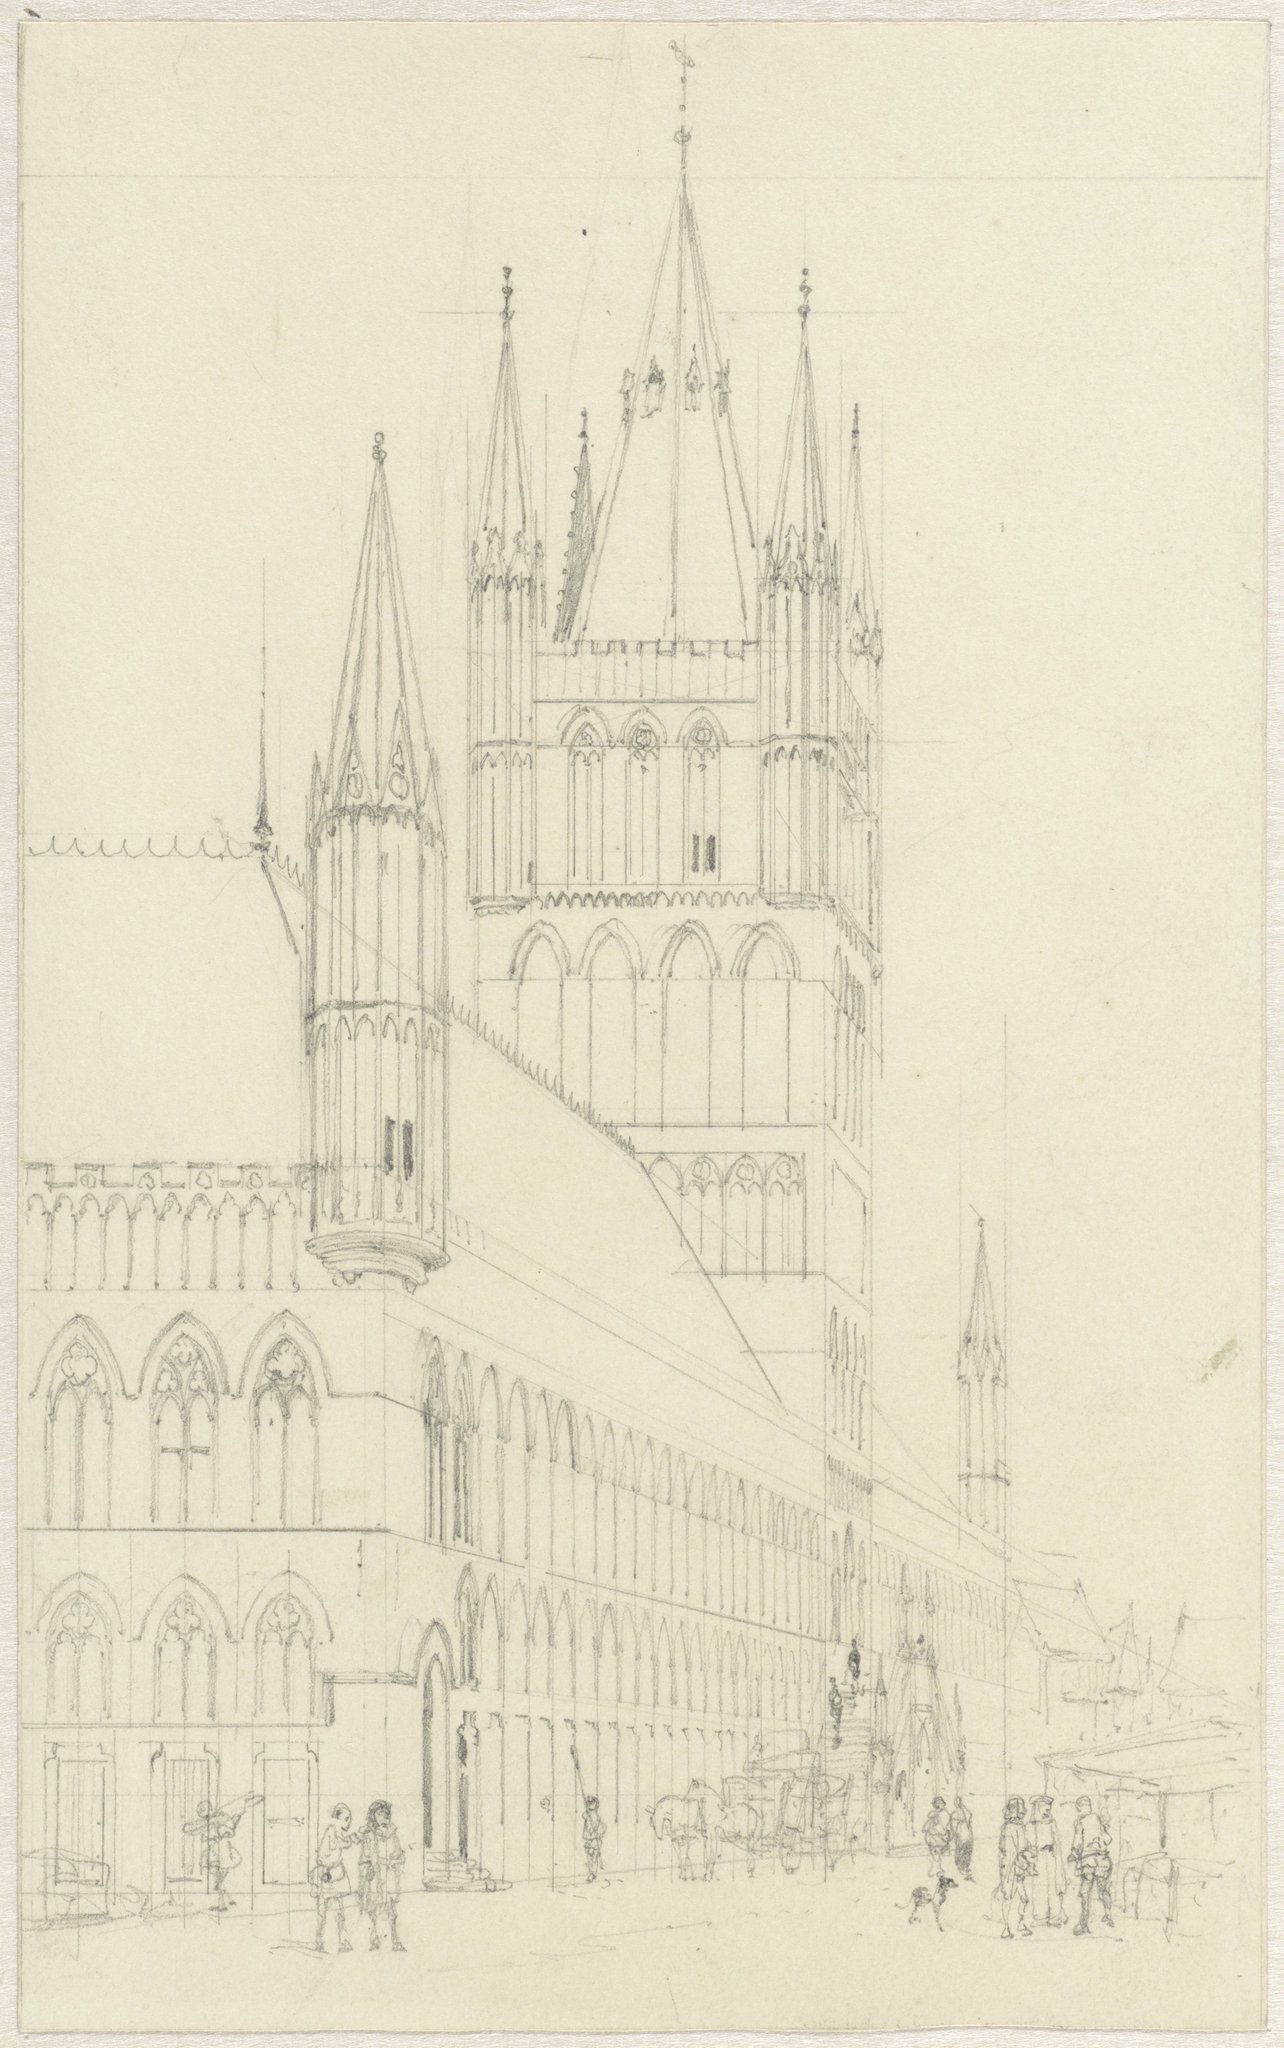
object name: drawing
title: Lakenhal te Yperen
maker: charles rochussen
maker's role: draughtsman, painter, print maker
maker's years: 1814-1894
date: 1824-1894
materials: paper, pencil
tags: tower, clock tower ~ monumental adornment, civic architecture; edifices; dwellings, street